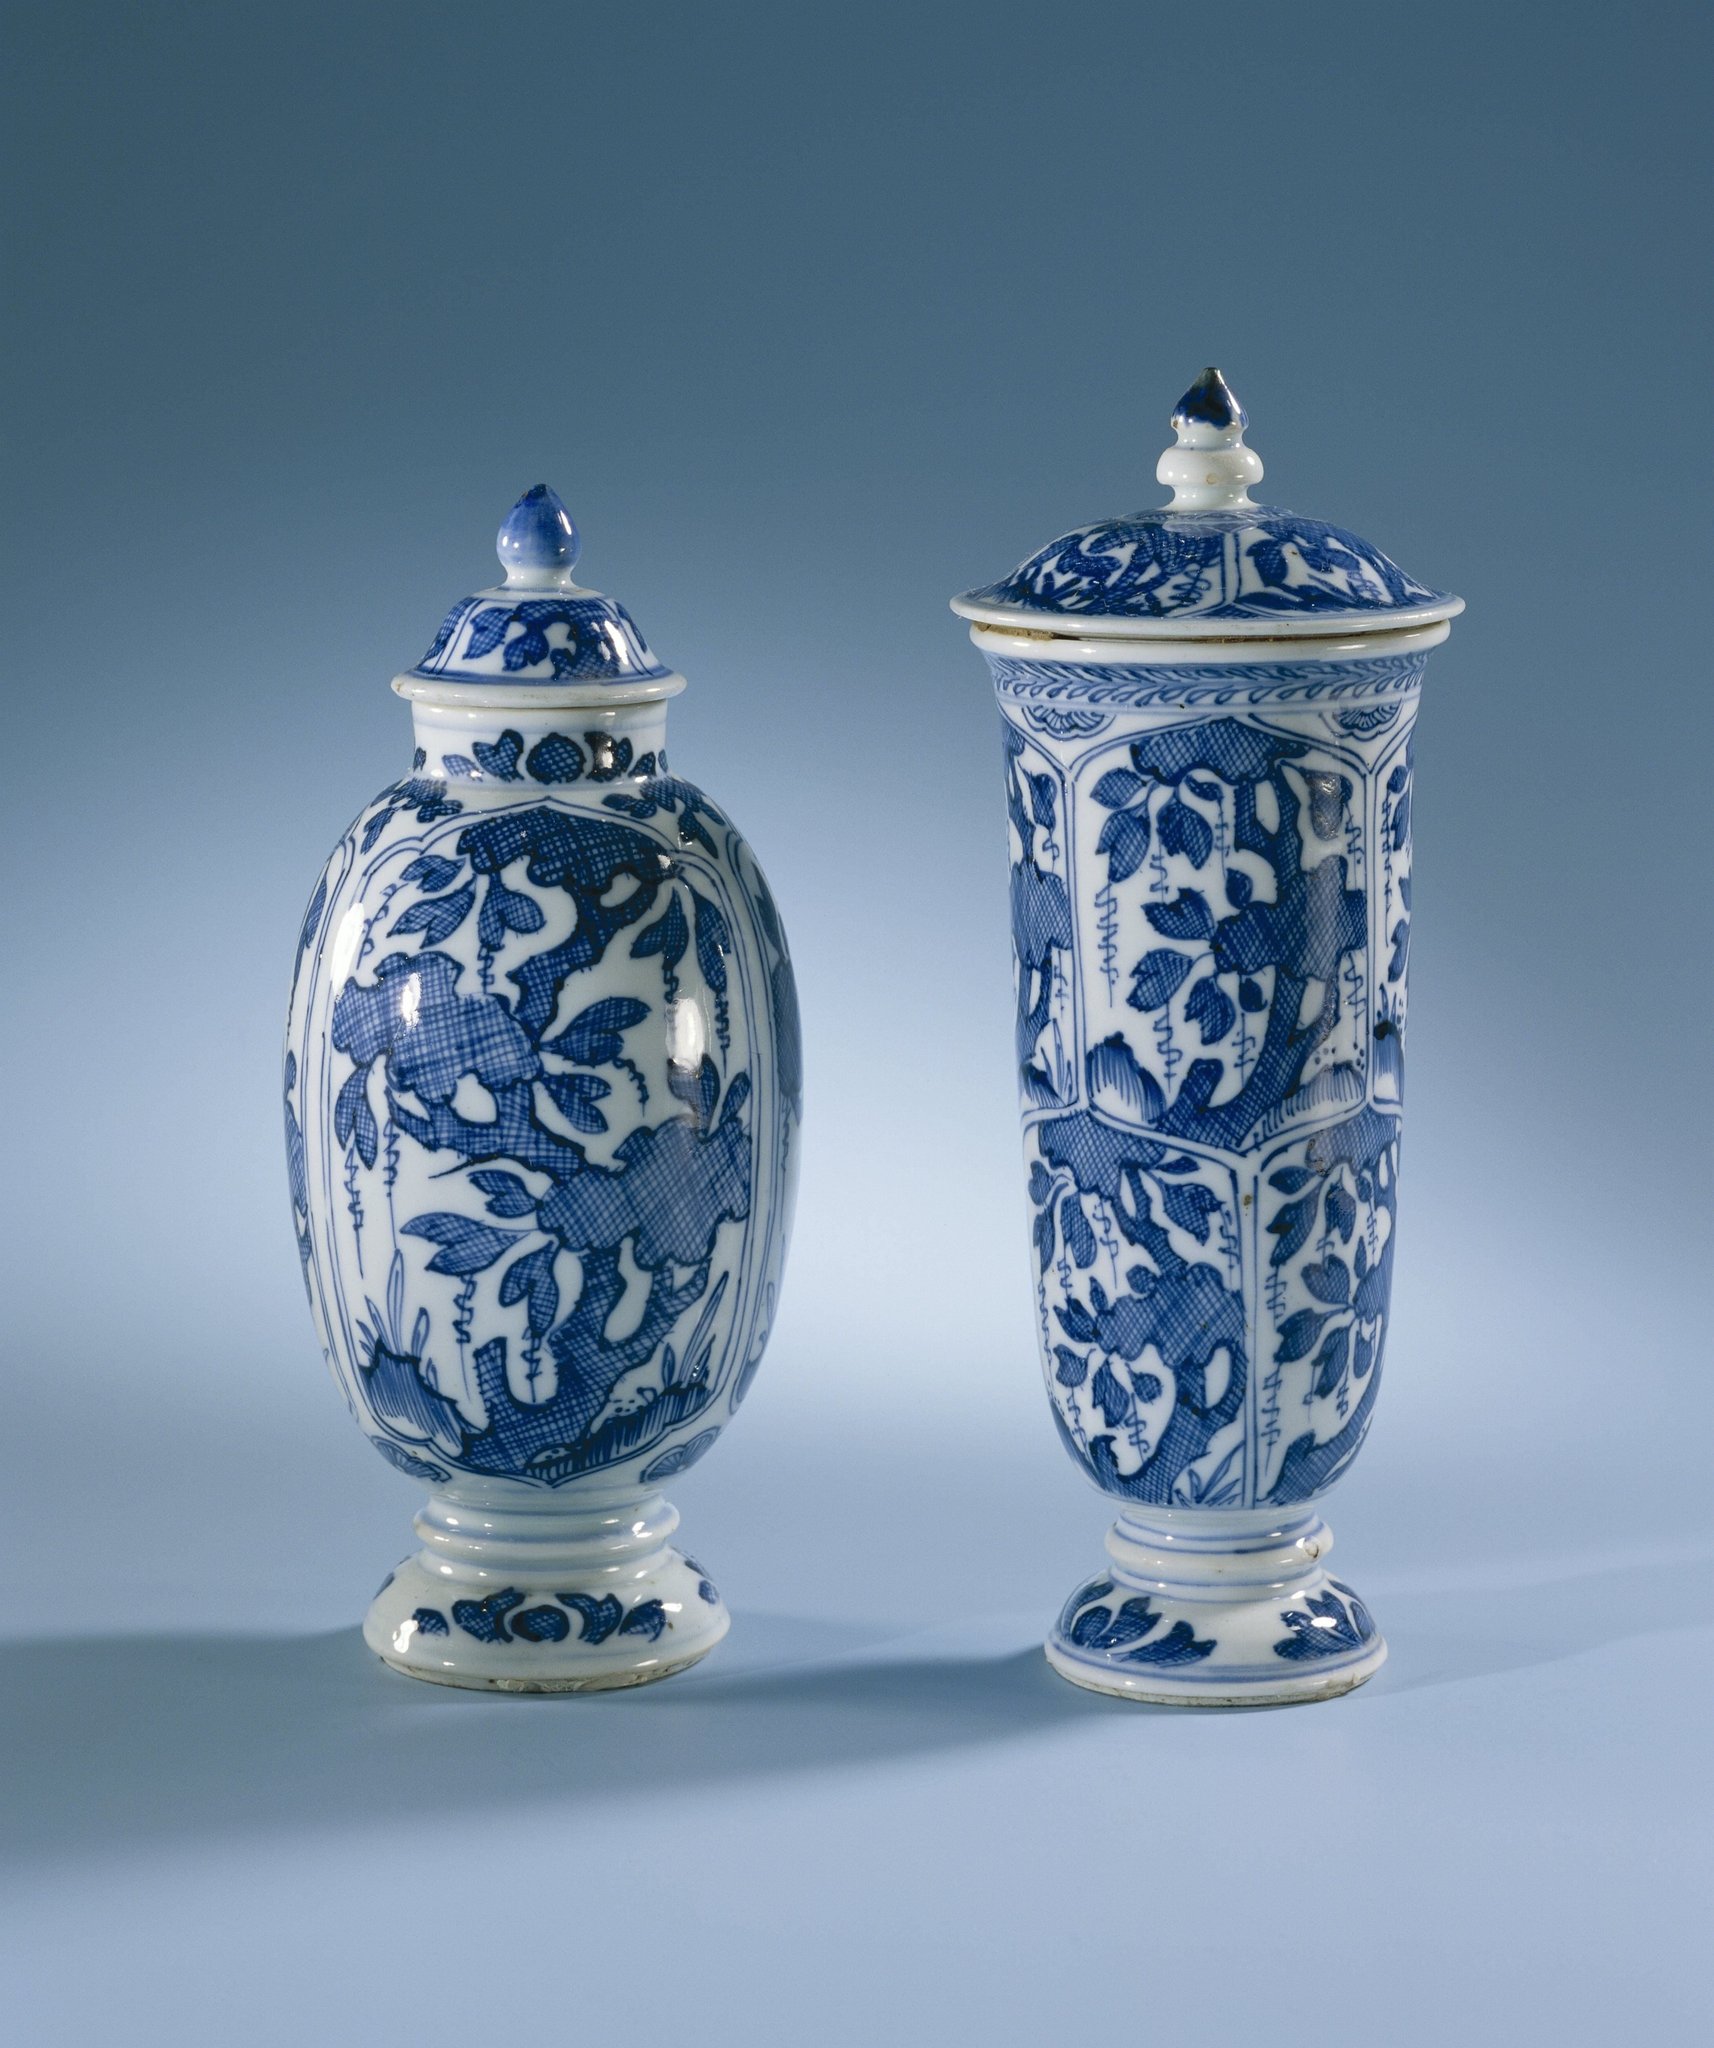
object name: covered jar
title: Covered jar with hatched plants in petal-shaped panels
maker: Anonymous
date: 1680-1720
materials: cobalt, glaze, paint, porcelain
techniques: firing, turning, vitrification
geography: china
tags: ornament derived from plant forms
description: Dekselpot van porselein met een uitgerekt, bolvormig lichaam en een hoge, spreidende voet, beschilderd in onderglazuur blauw. Op de wand langwerpige, bloembladvormige vakken met daarin bloeiende planten aangezet met arceerwerk; tussen de vakken langs de rand en de voet telkens een halve bloem. De rand en de voet met driemaal een gestileerde bloem. De deksel met dezelfde decoratie. Blauw-wit.